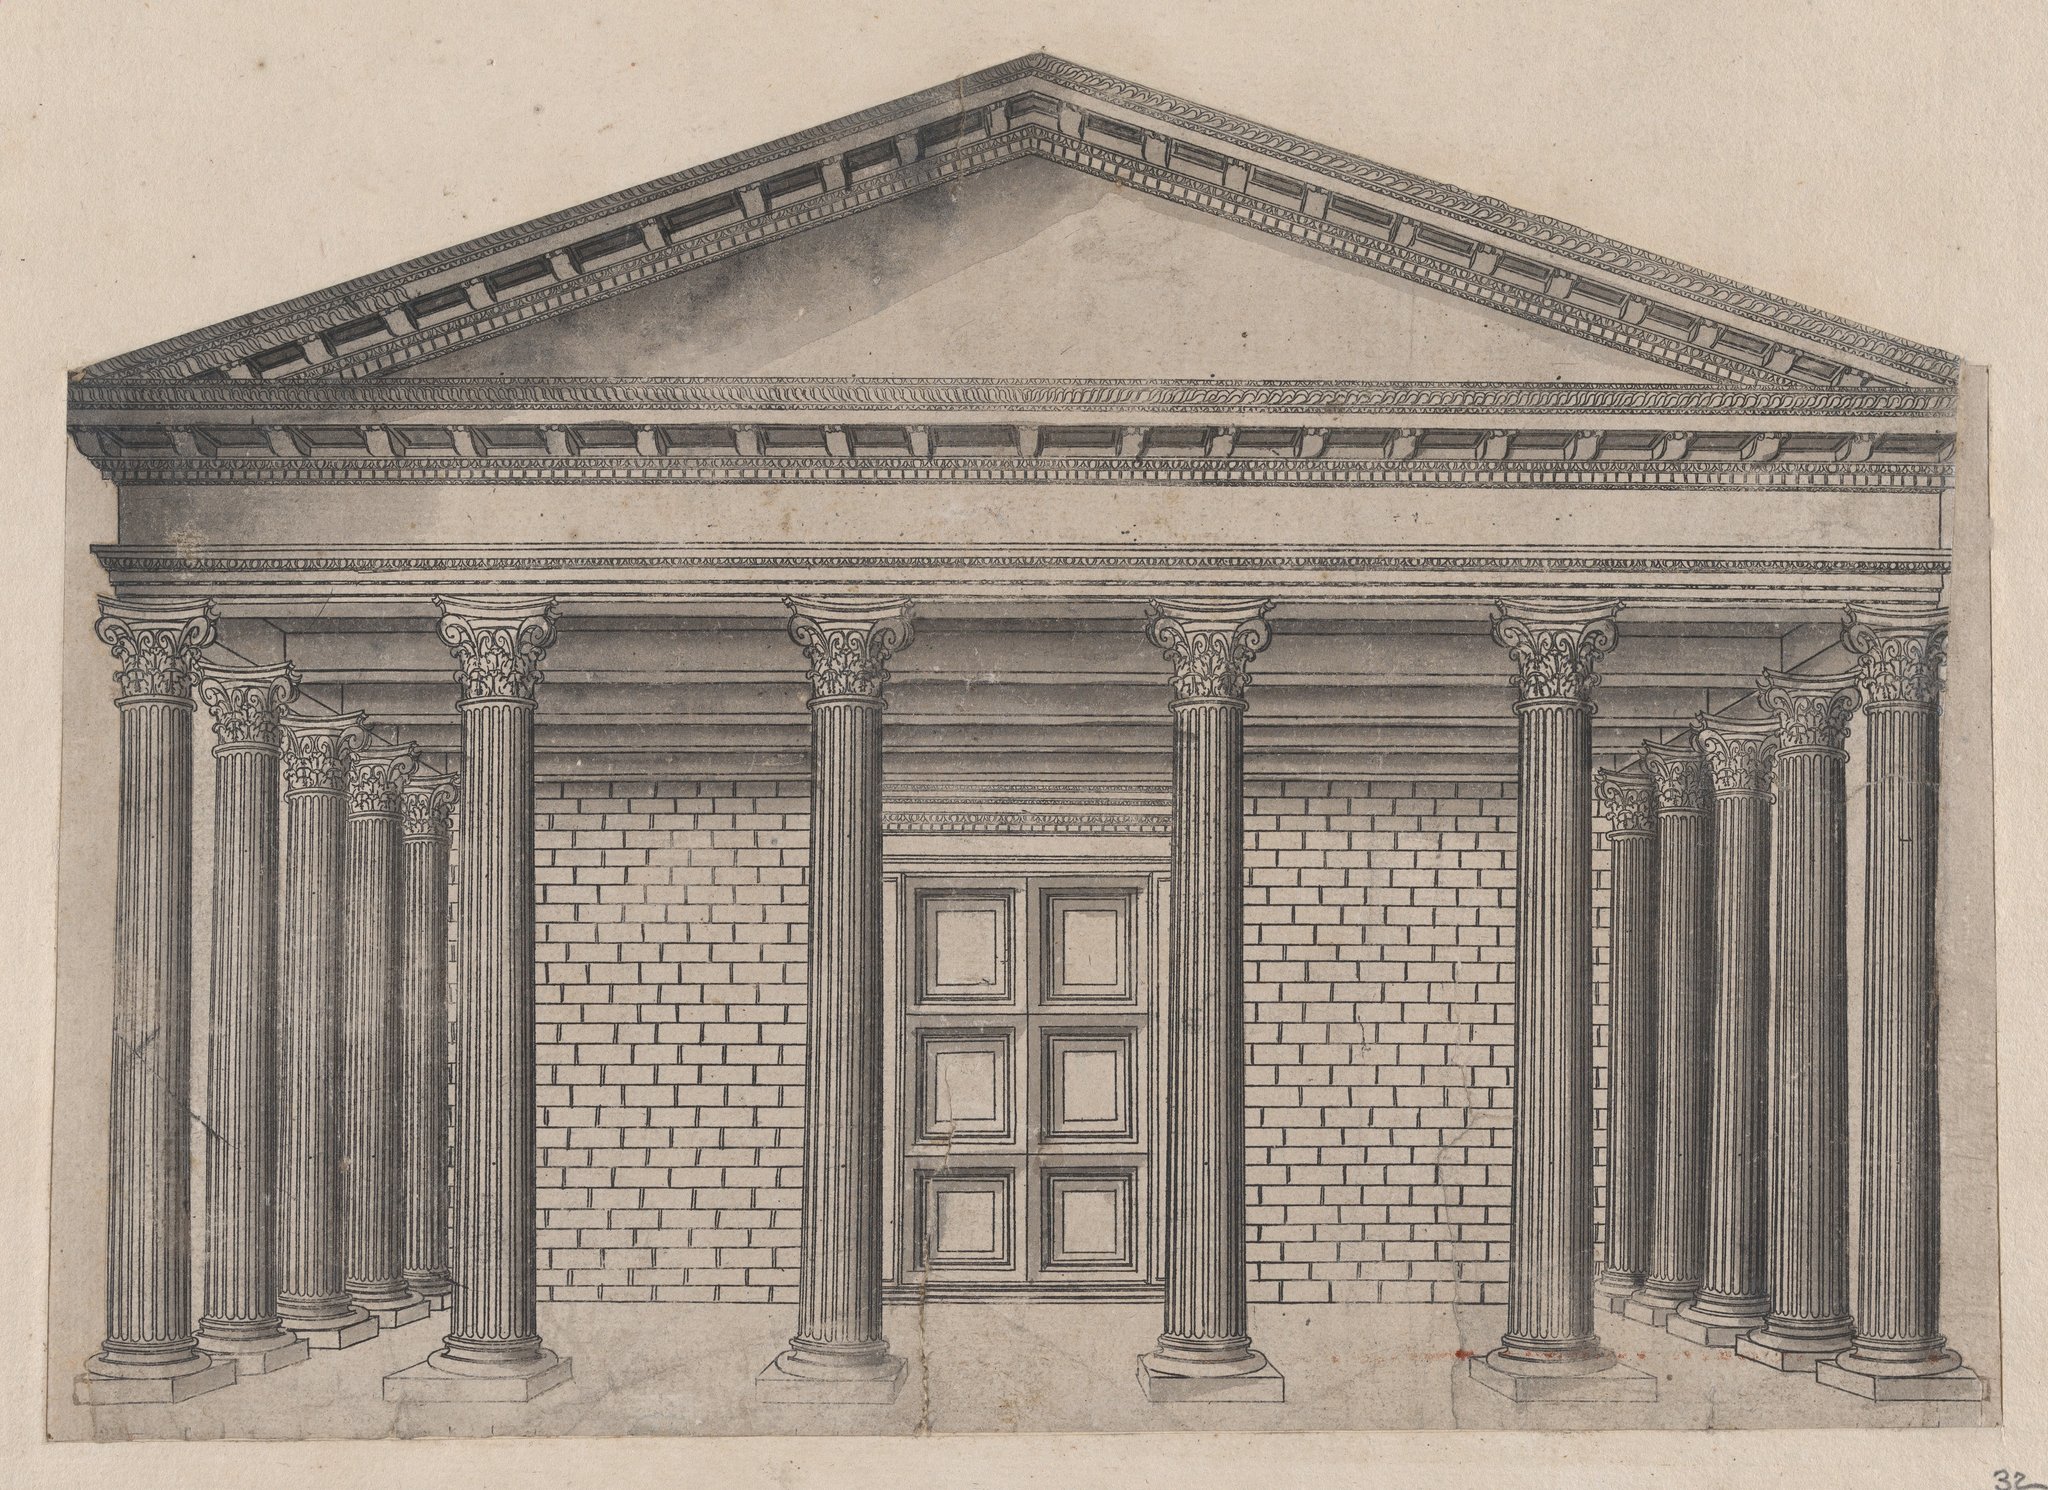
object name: print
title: Maison antique a Nymmes, from "Speculum Romanae Magnificentiae"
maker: Anonymous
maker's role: artist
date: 1501-1600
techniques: brush, engraving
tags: architecture,rome